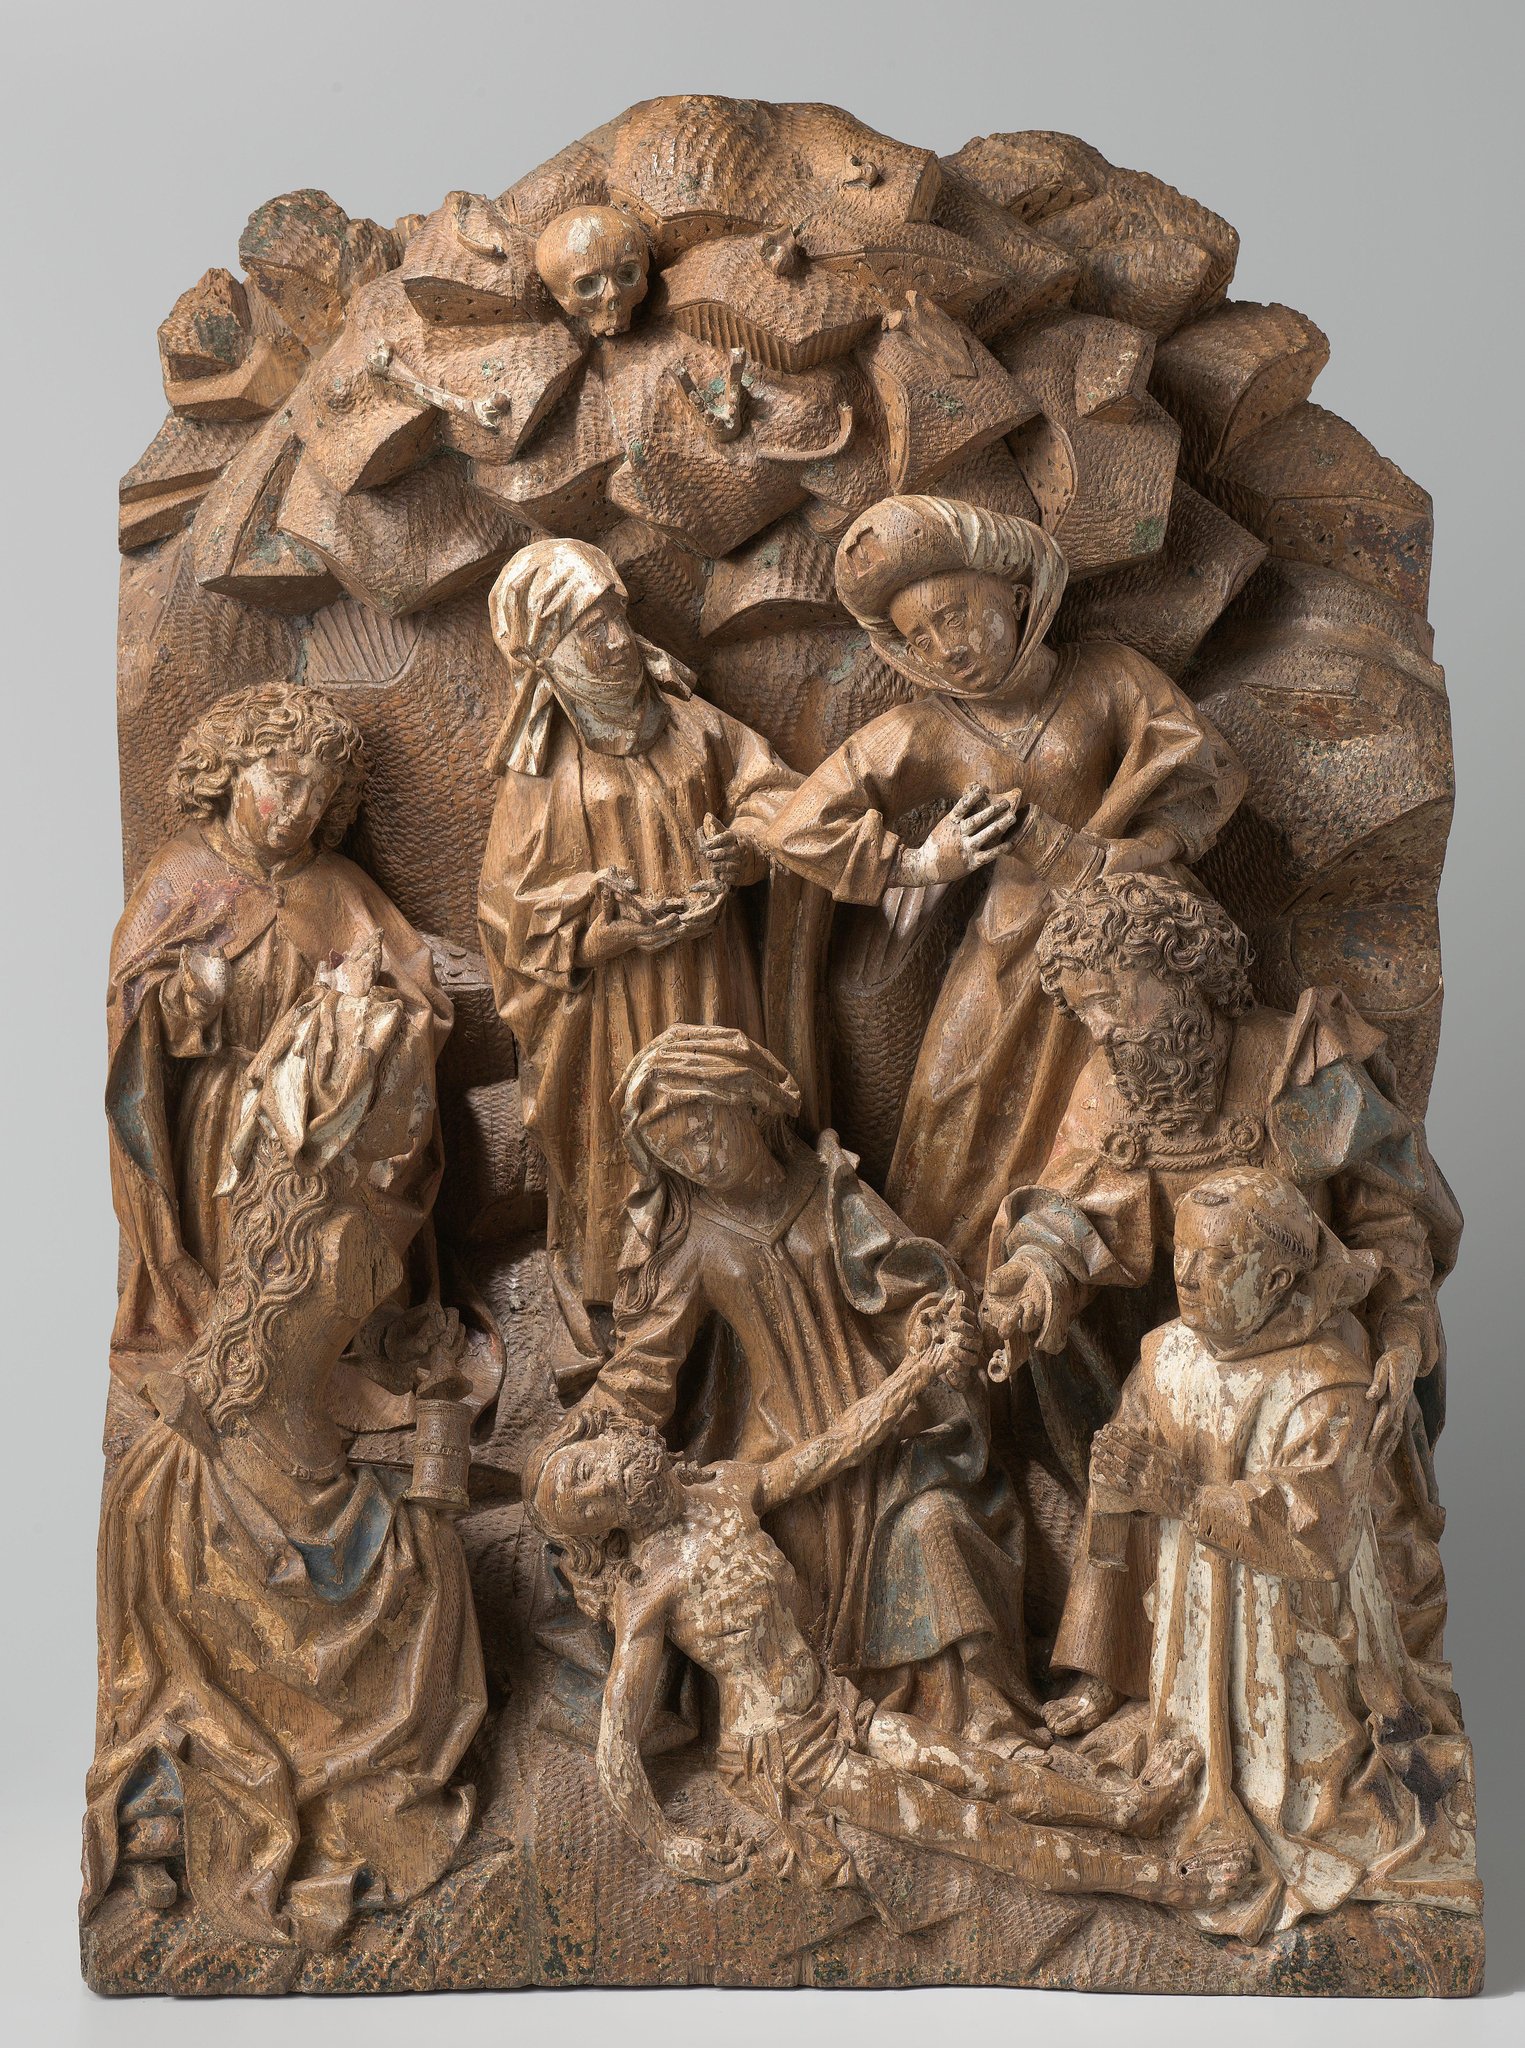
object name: sculpture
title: The Lamentation of Christ, from a Carthusian House Altar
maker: master arnt of kalkar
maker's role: sculptor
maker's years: -1492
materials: wood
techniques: polychromy, carved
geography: kalkar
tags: christ's body lying on the ground (+ donor(s), supplicant(s), whether or not with patron saint(s))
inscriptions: label, on the reverse, printed and inscribed: ‘Tentoonstelling, “Maria in de Kunst” Maastricht 1947, No. 56. Onderwerp Bewening Eigenaar Rectoraatskerk, Boekoel’, on the reverse, printed and inscribed: ‘Tentoonstelling Limburgse Kunst Raadhuis – Heerlen – 1948. Onderwerp: Bewening v. Christus Eigenaar: Rectoraatskerk, Boekel Nr. Swalmen (Dhr. A. Tissen Minderbroederstraat Roermond.)’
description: This sculpture group once formed the central section of a small altar for the Carthusian monk who is himself shown kneeling at lower right. The altar would have stood in his cell where he could meditate on Christ’s Passion in solitude. The relief probably came from the Carthusian monastery in Roermond.